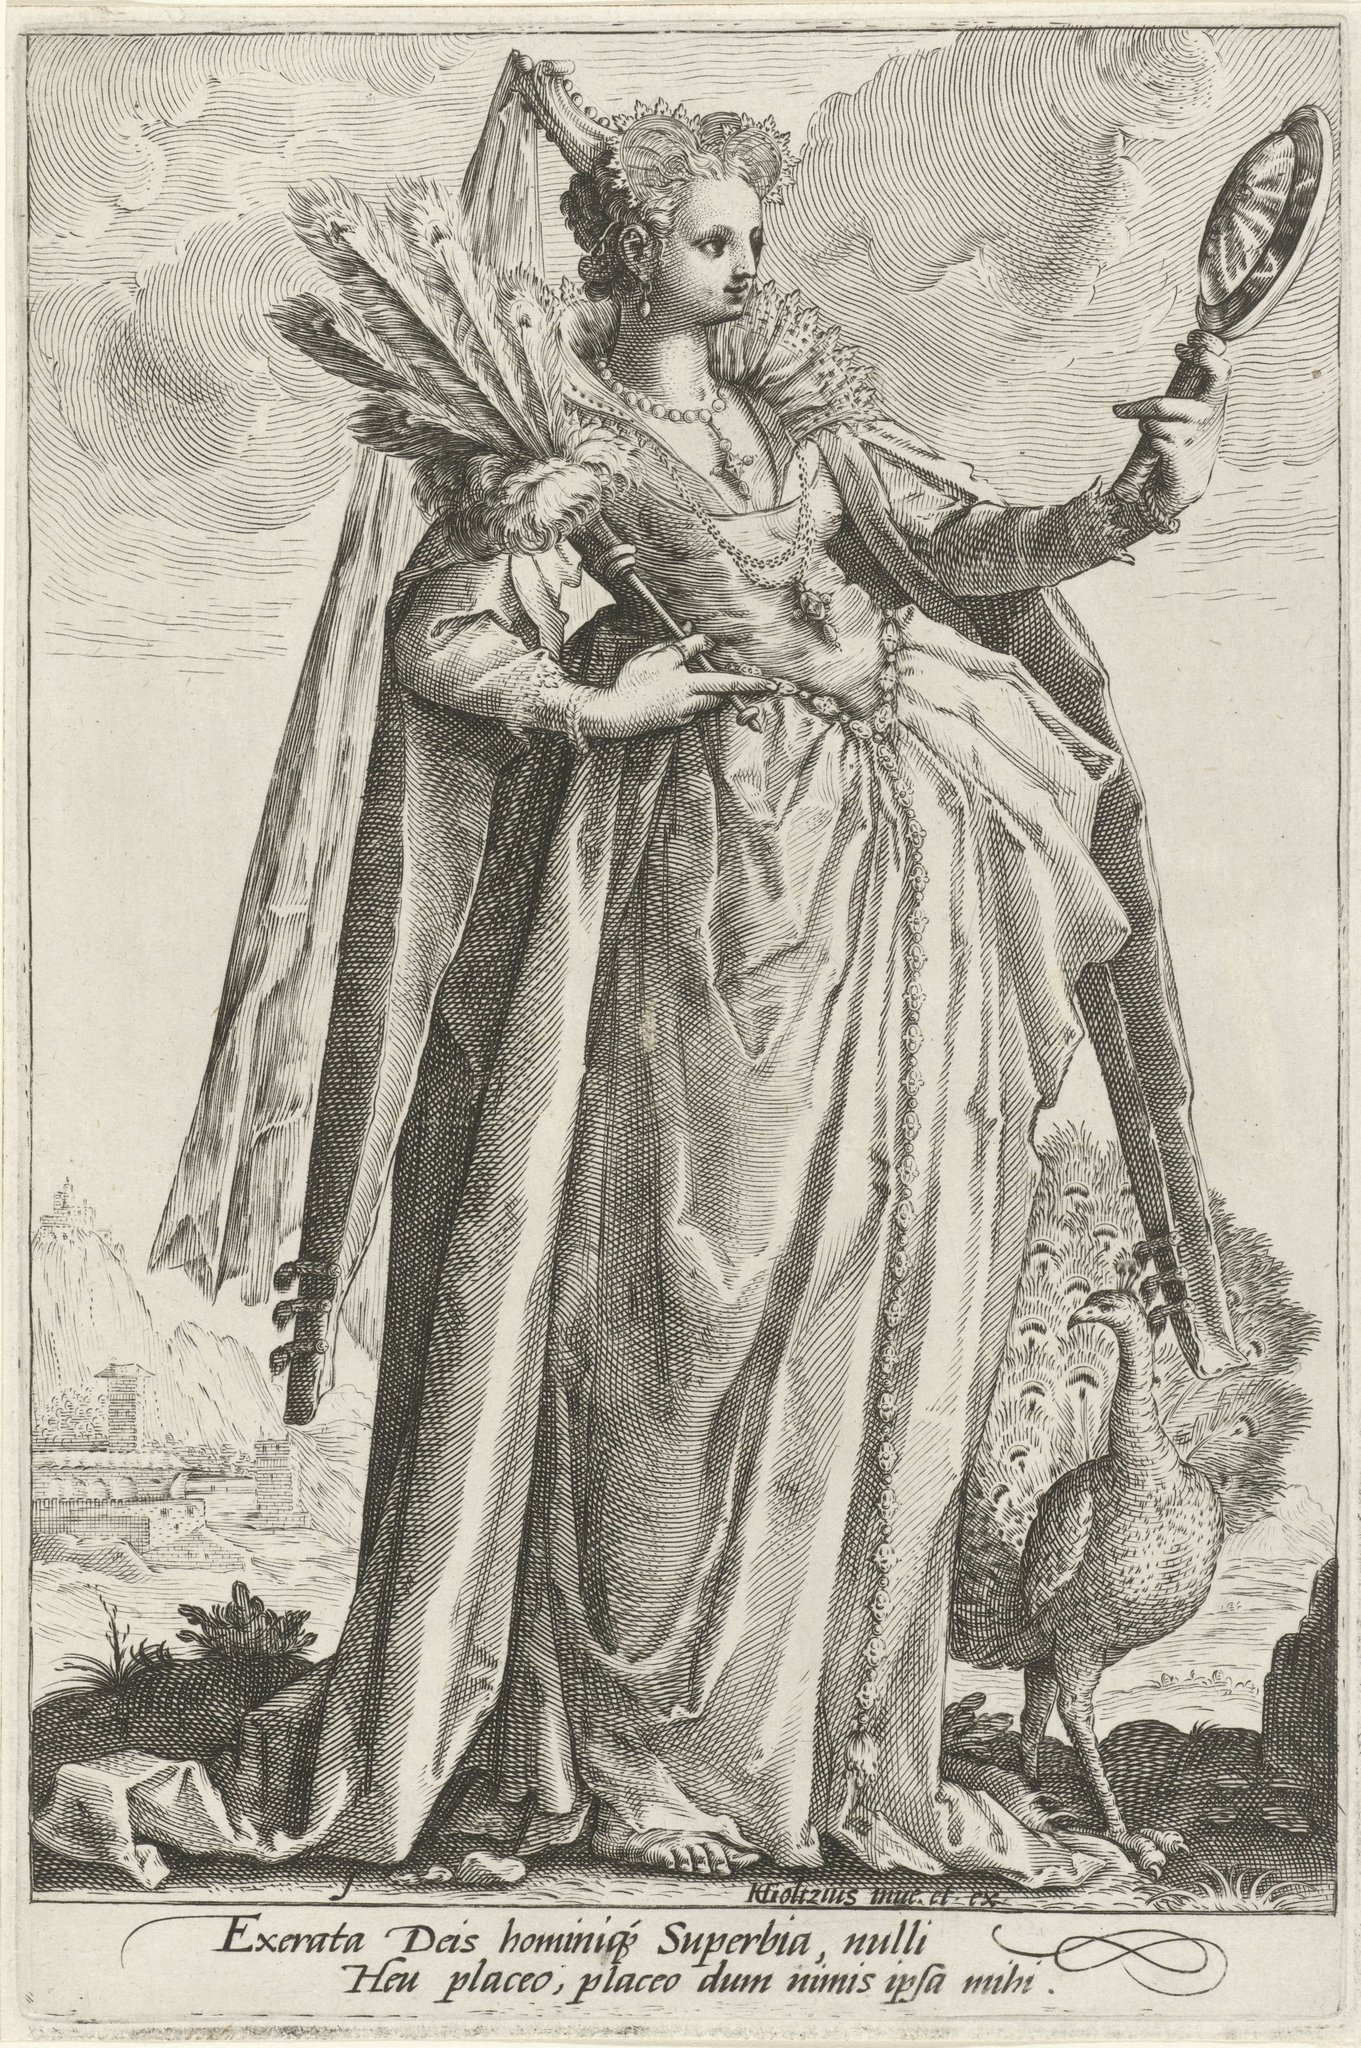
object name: print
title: Hoogmoed (Superbia)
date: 1585-1589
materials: paper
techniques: engraving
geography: haarlem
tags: pride; 'superbia' (ripa) ~ personification of one of the seven deadly sins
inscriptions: collector's mark: Lugt 240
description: De gepersonifieerde Hoogmoed; een vrouwenfiguur in rijk gewaad met spiegel in de hand, staande naast een pauw.